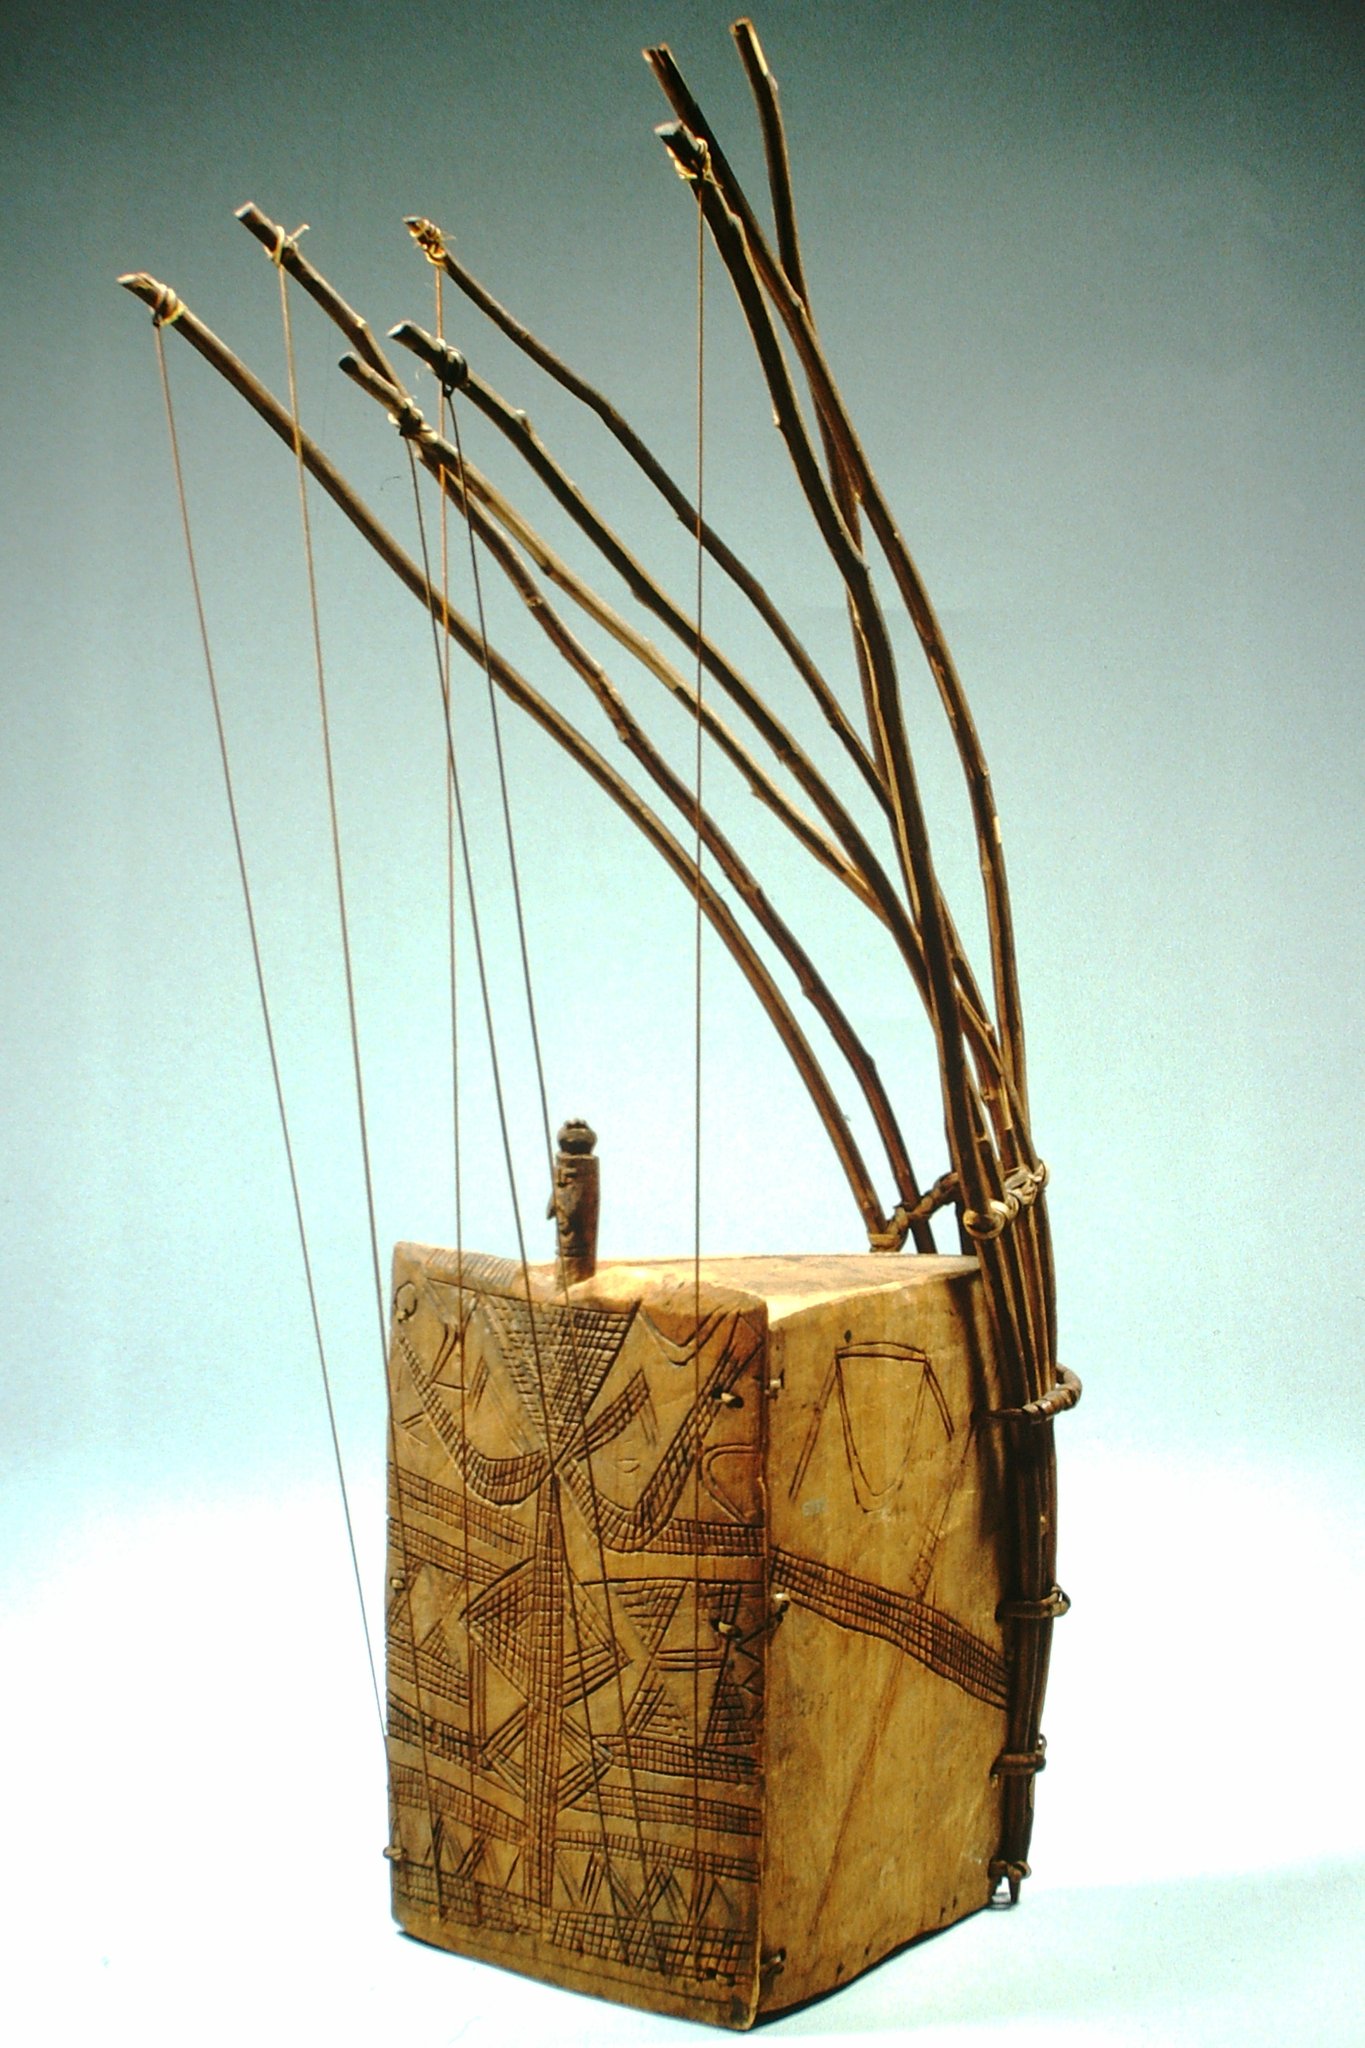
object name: ubo akwara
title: Ubo akwara (pluriarc)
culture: igbo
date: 1867-1900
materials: fiber, wood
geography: nigeria